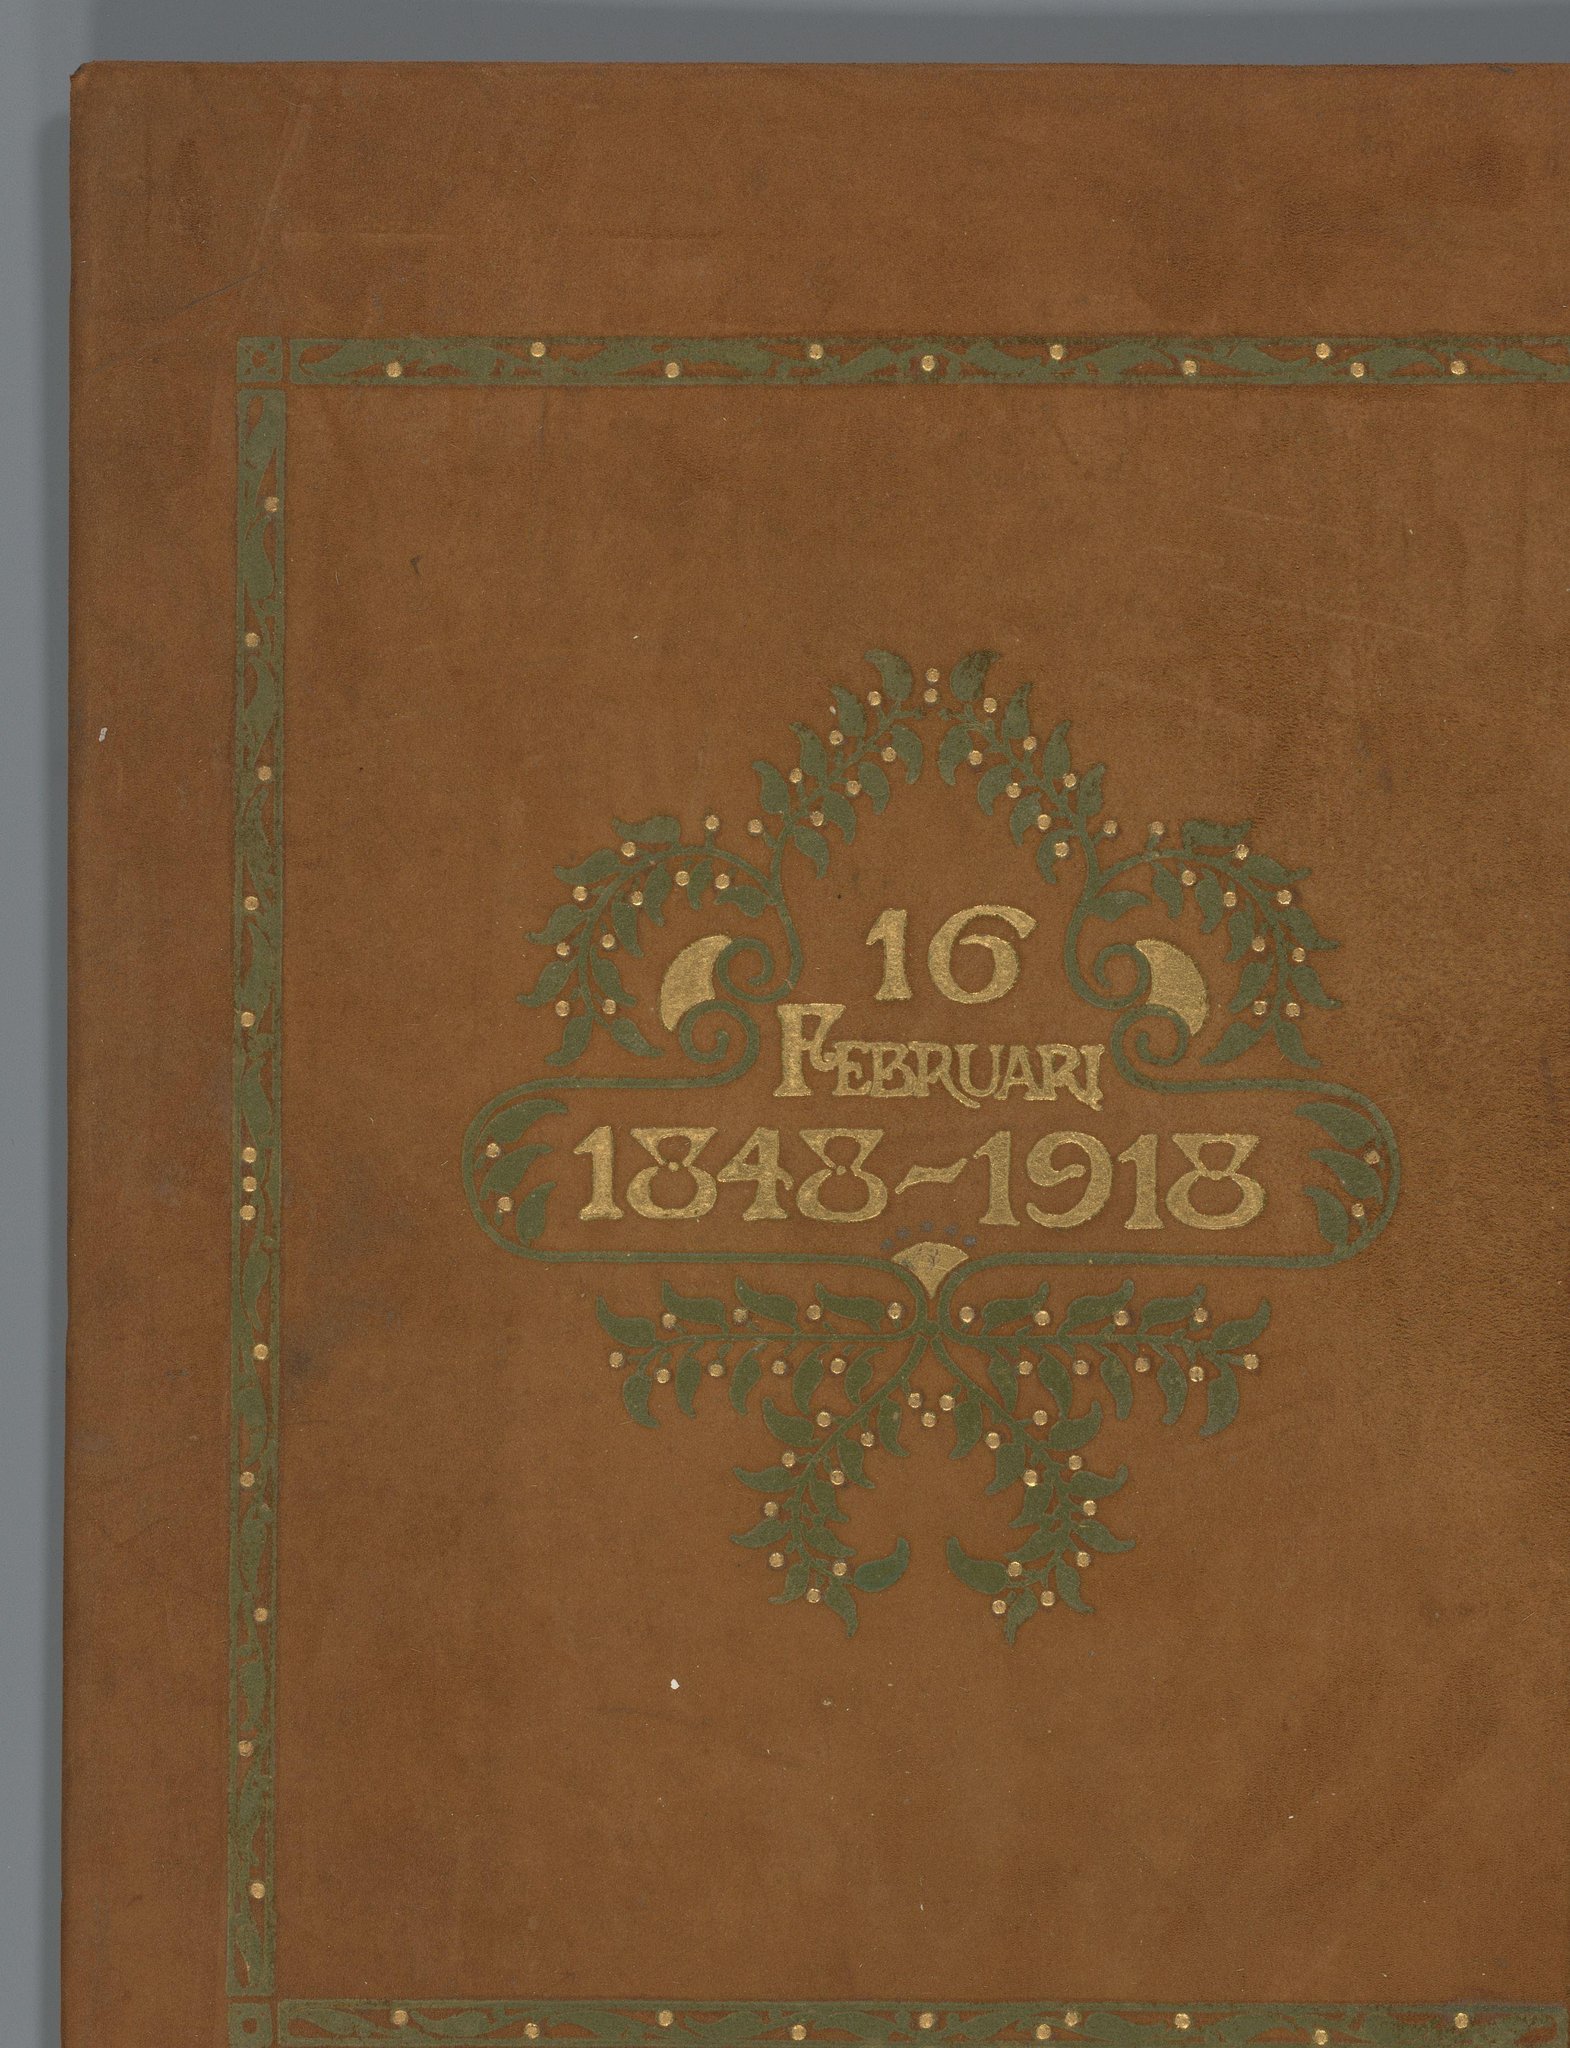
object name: binding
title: Band voor een album voor Prof. Hugo de Vries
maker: Anonymous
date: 1918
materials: cardboard, leather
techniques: gold embossing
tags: hugo de vries, flowers ~ ornament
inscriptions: annotation: ‘band van album./ Prof Hugo De Vries’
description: Proefband van een album voor professor Hugo de Vries met portretten van binnen- en buitenlandse vakgenoten.